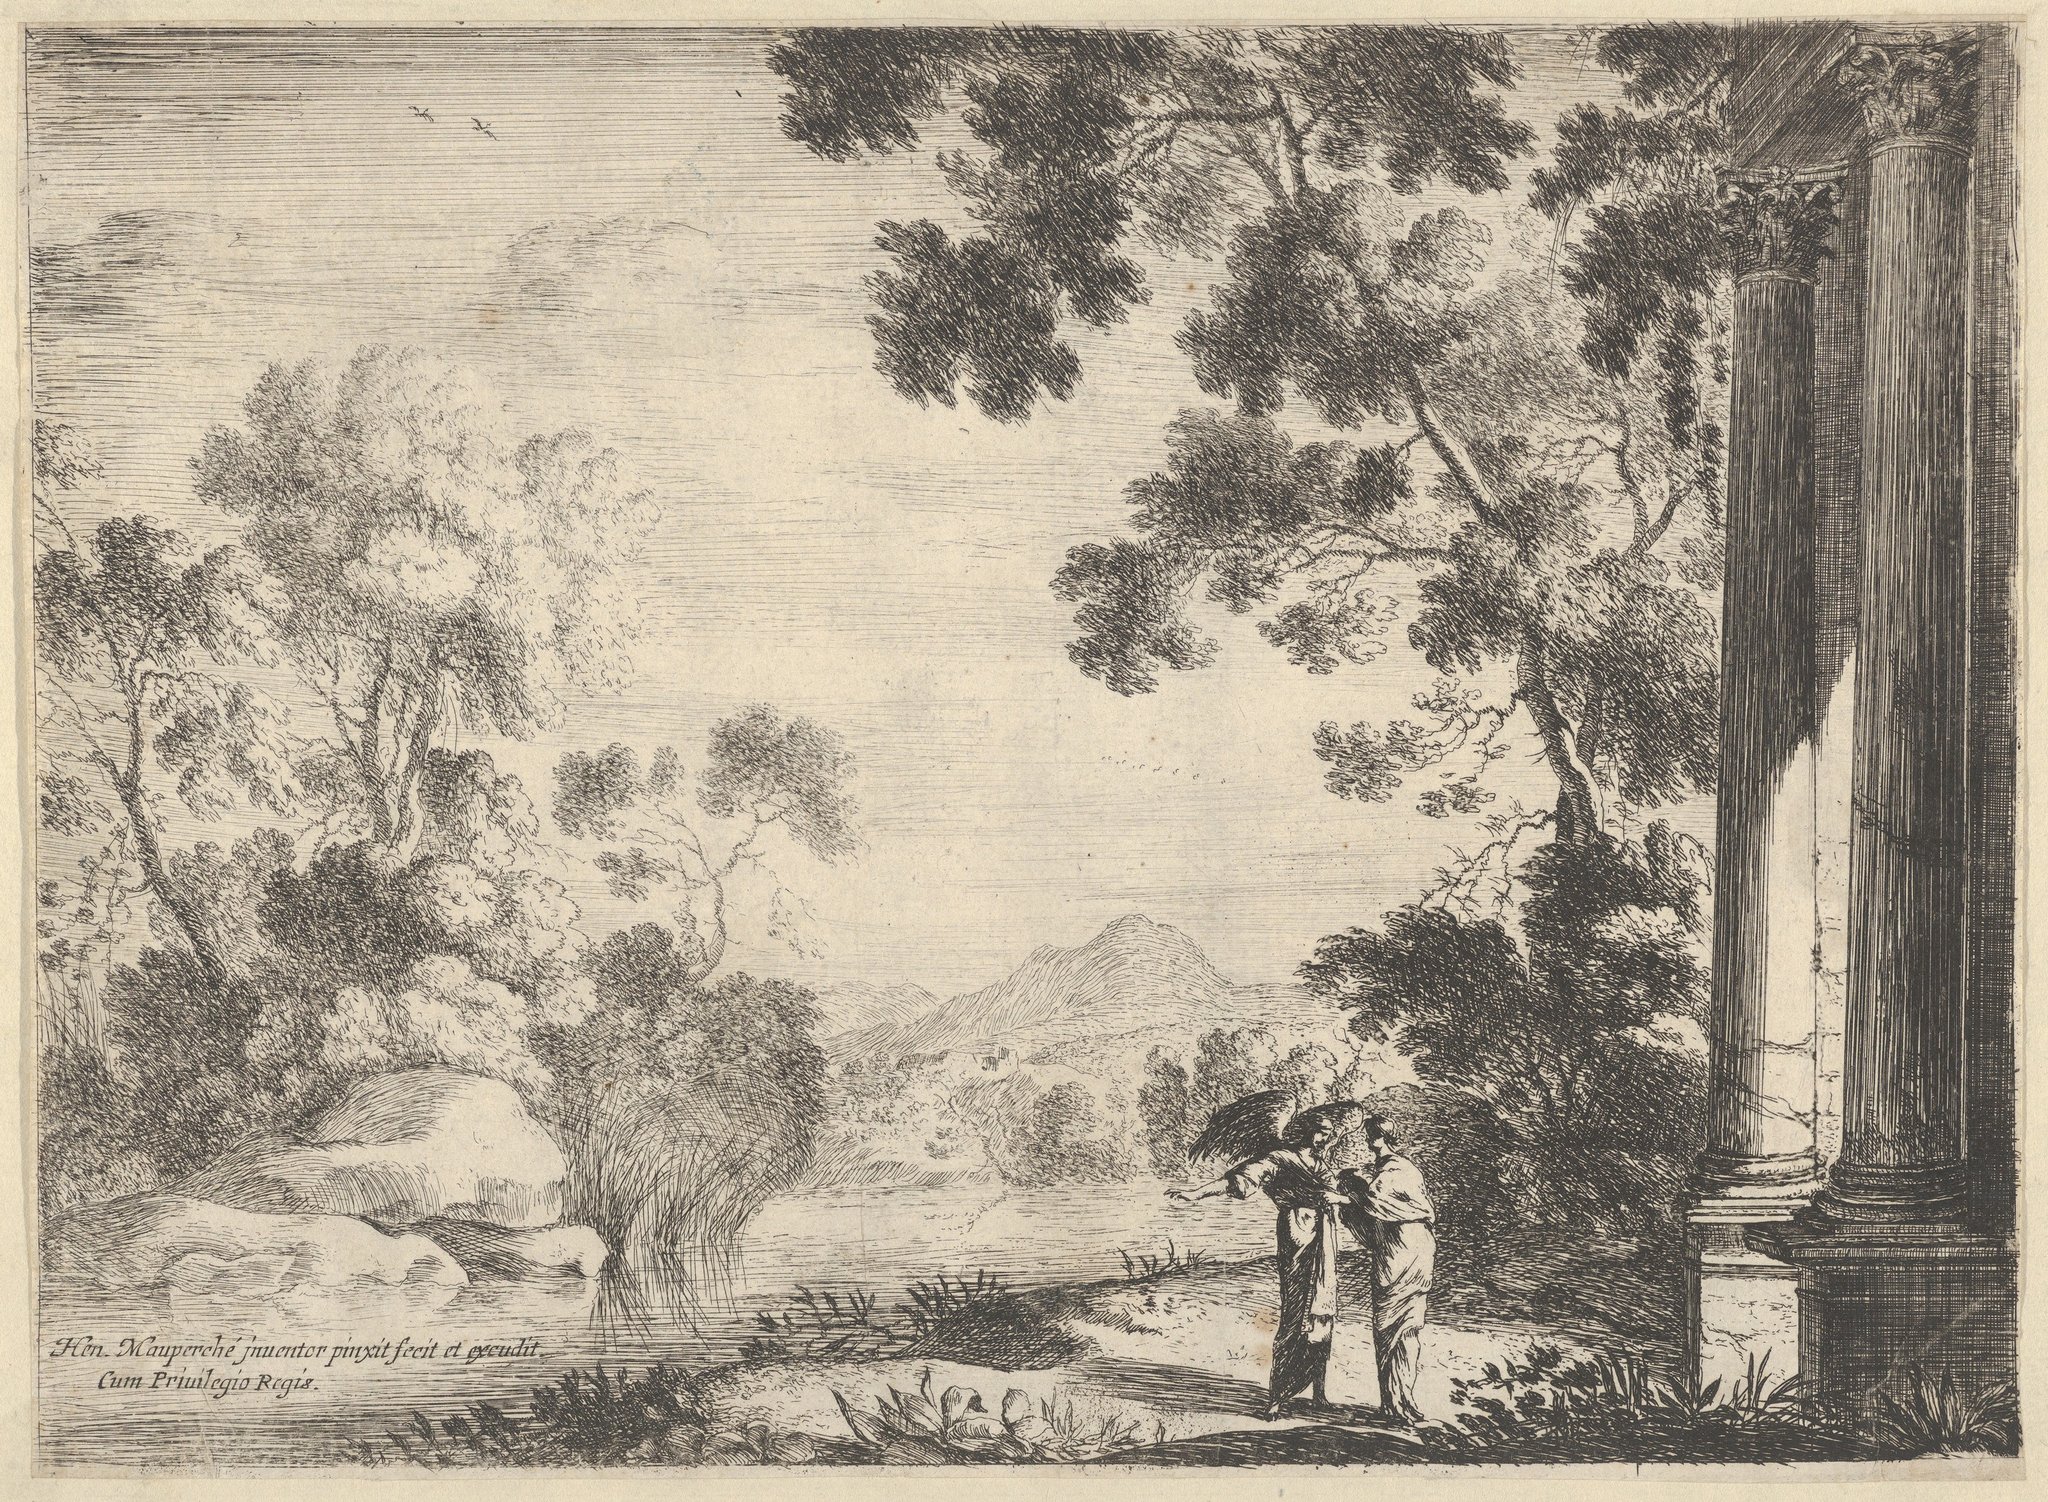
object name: print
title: The Angel Advises Tobie (L'Ange conseillant Tobie)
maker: henri mauperché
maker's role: artist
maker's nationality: french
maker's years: 1602-1686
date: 1630-1680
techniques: etching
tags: men,landscapes,angels